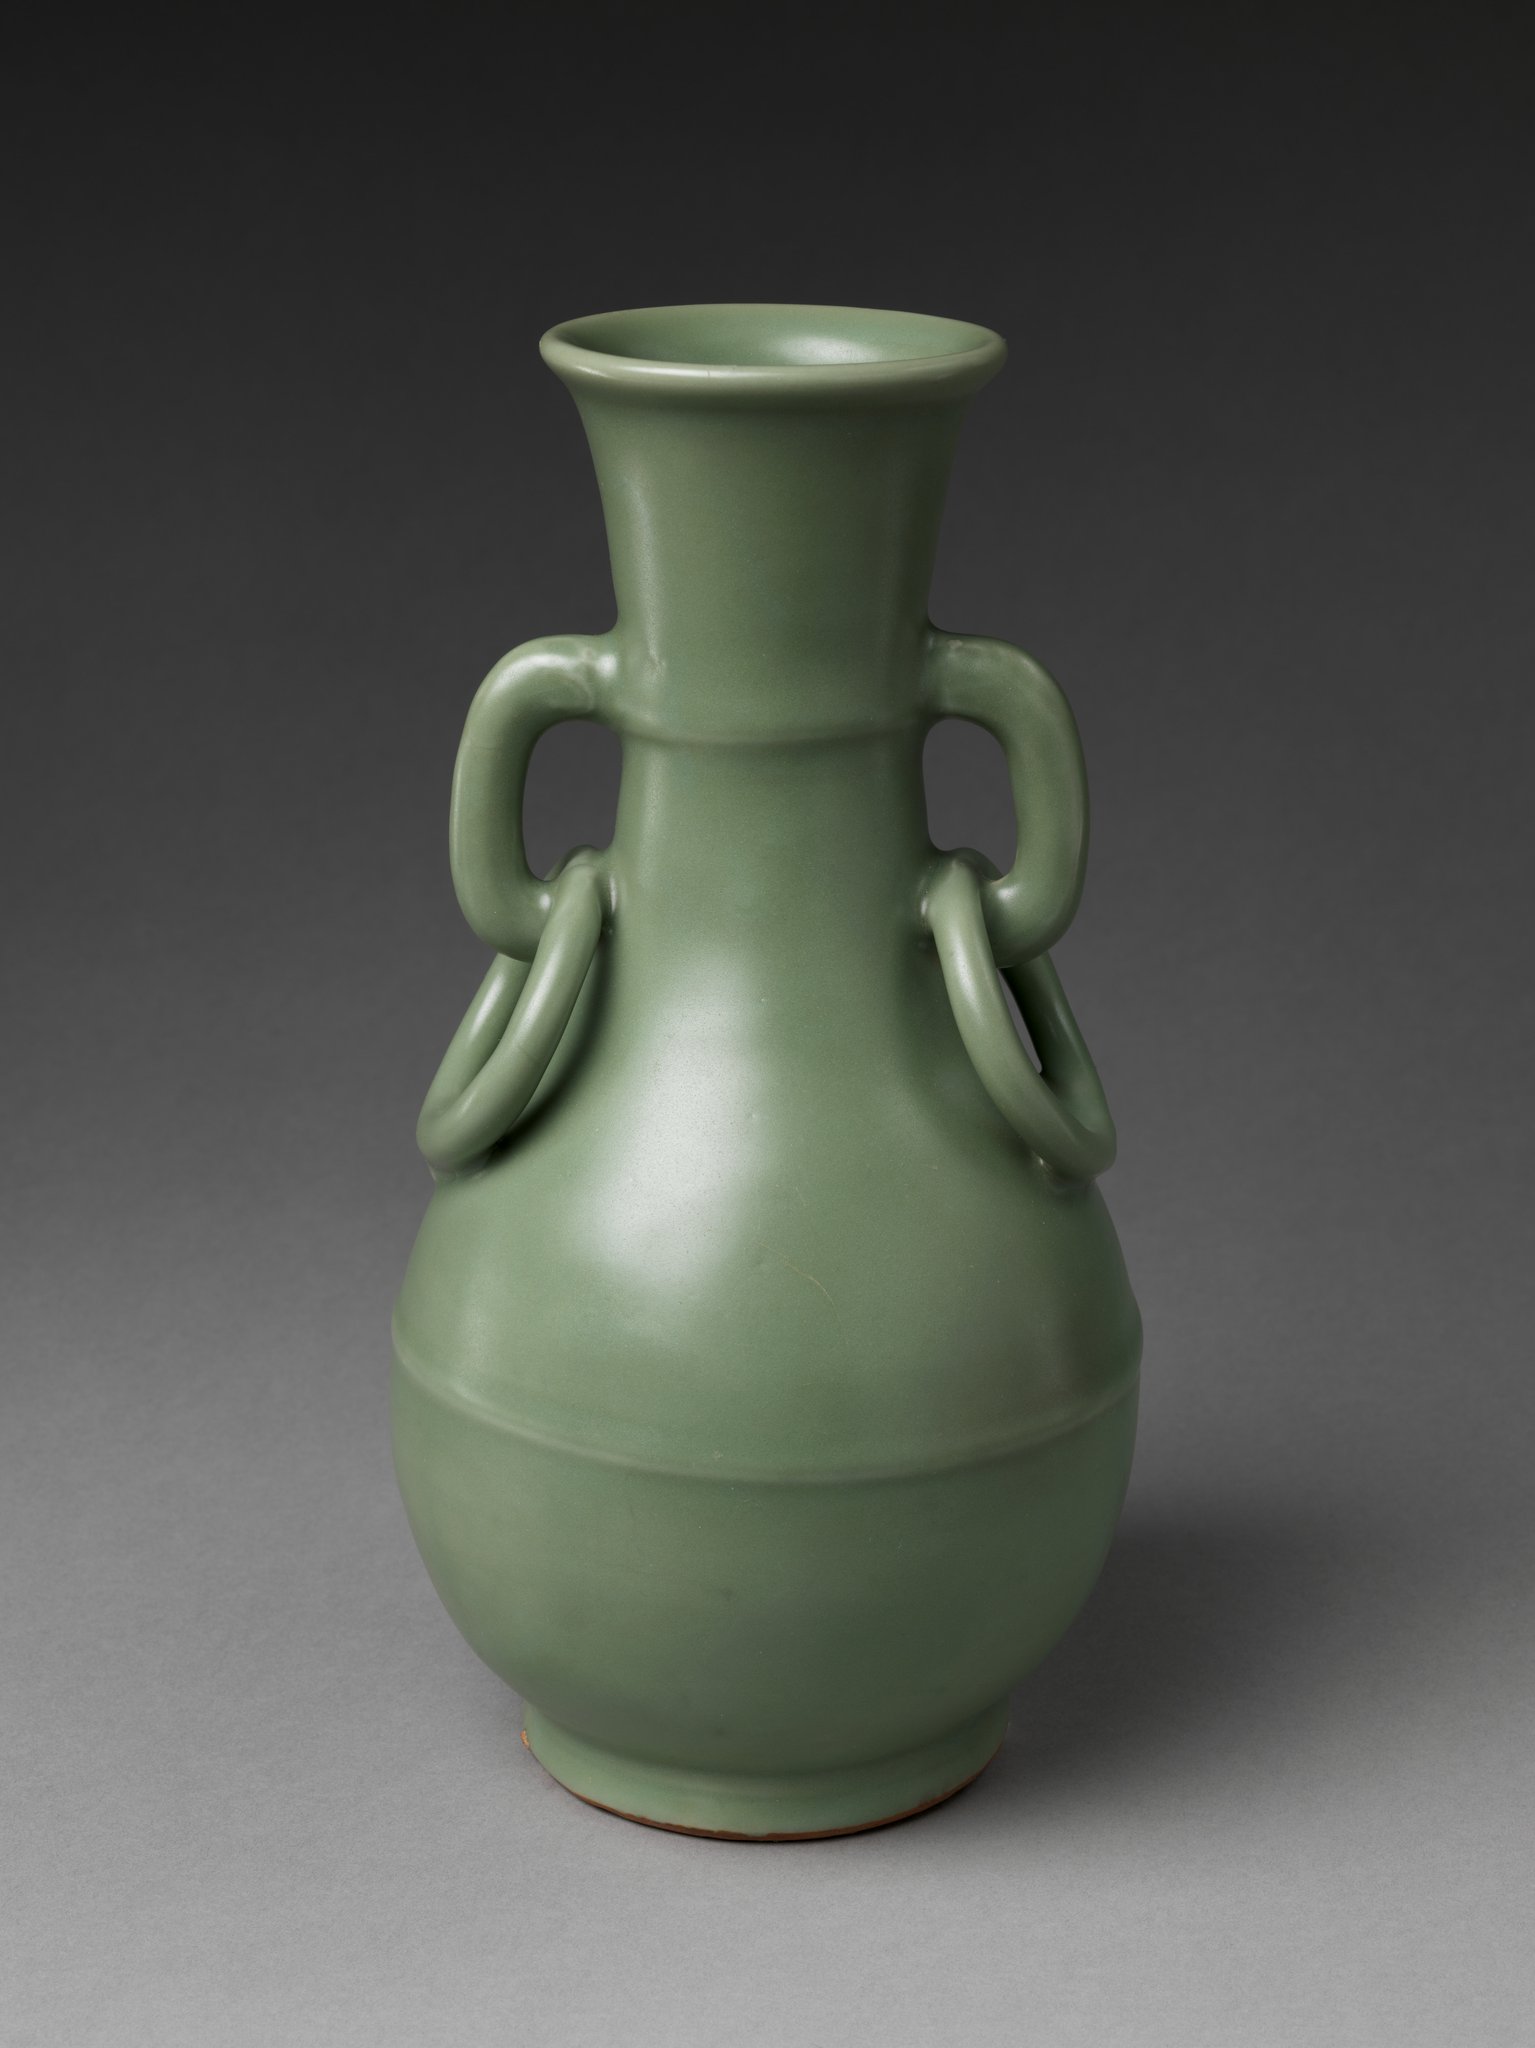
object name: vase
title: Vase in Shape of Ancient Bronze Vessel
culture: chinese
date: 1401-1600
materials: ceramic glaze, glaze, porcelain